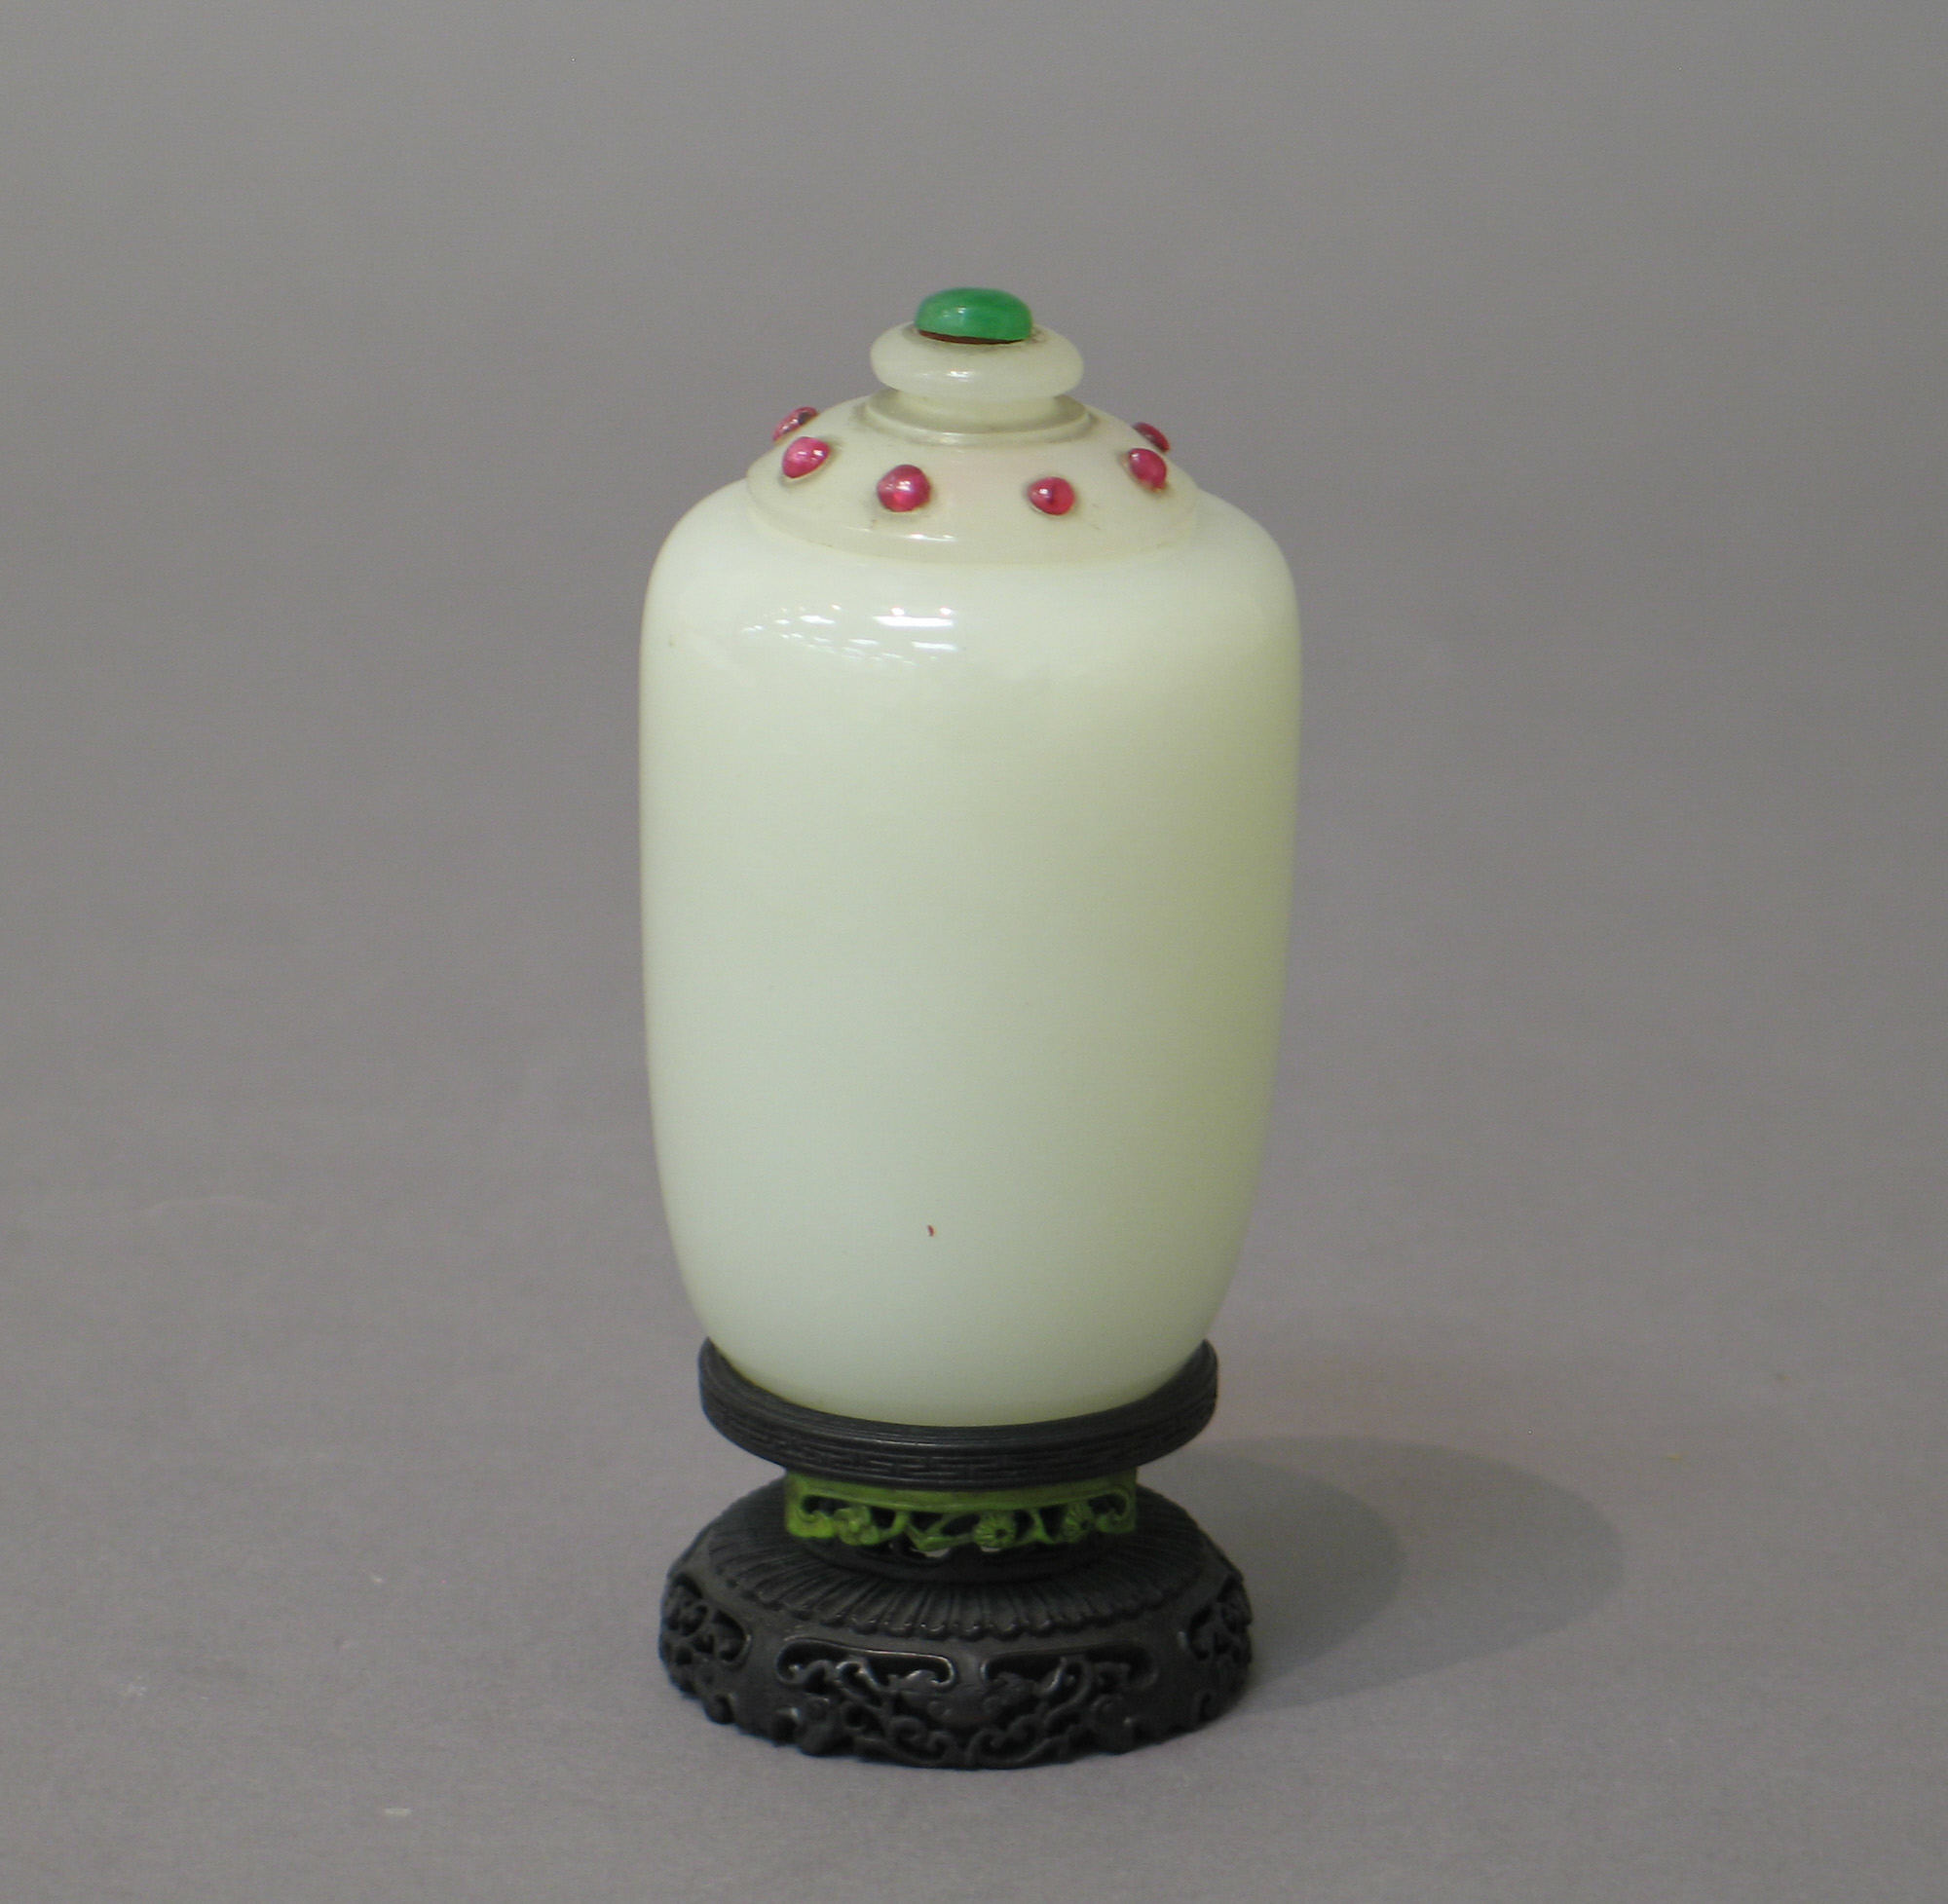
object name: jar with cover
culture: chinese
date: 1736-1795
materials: jade